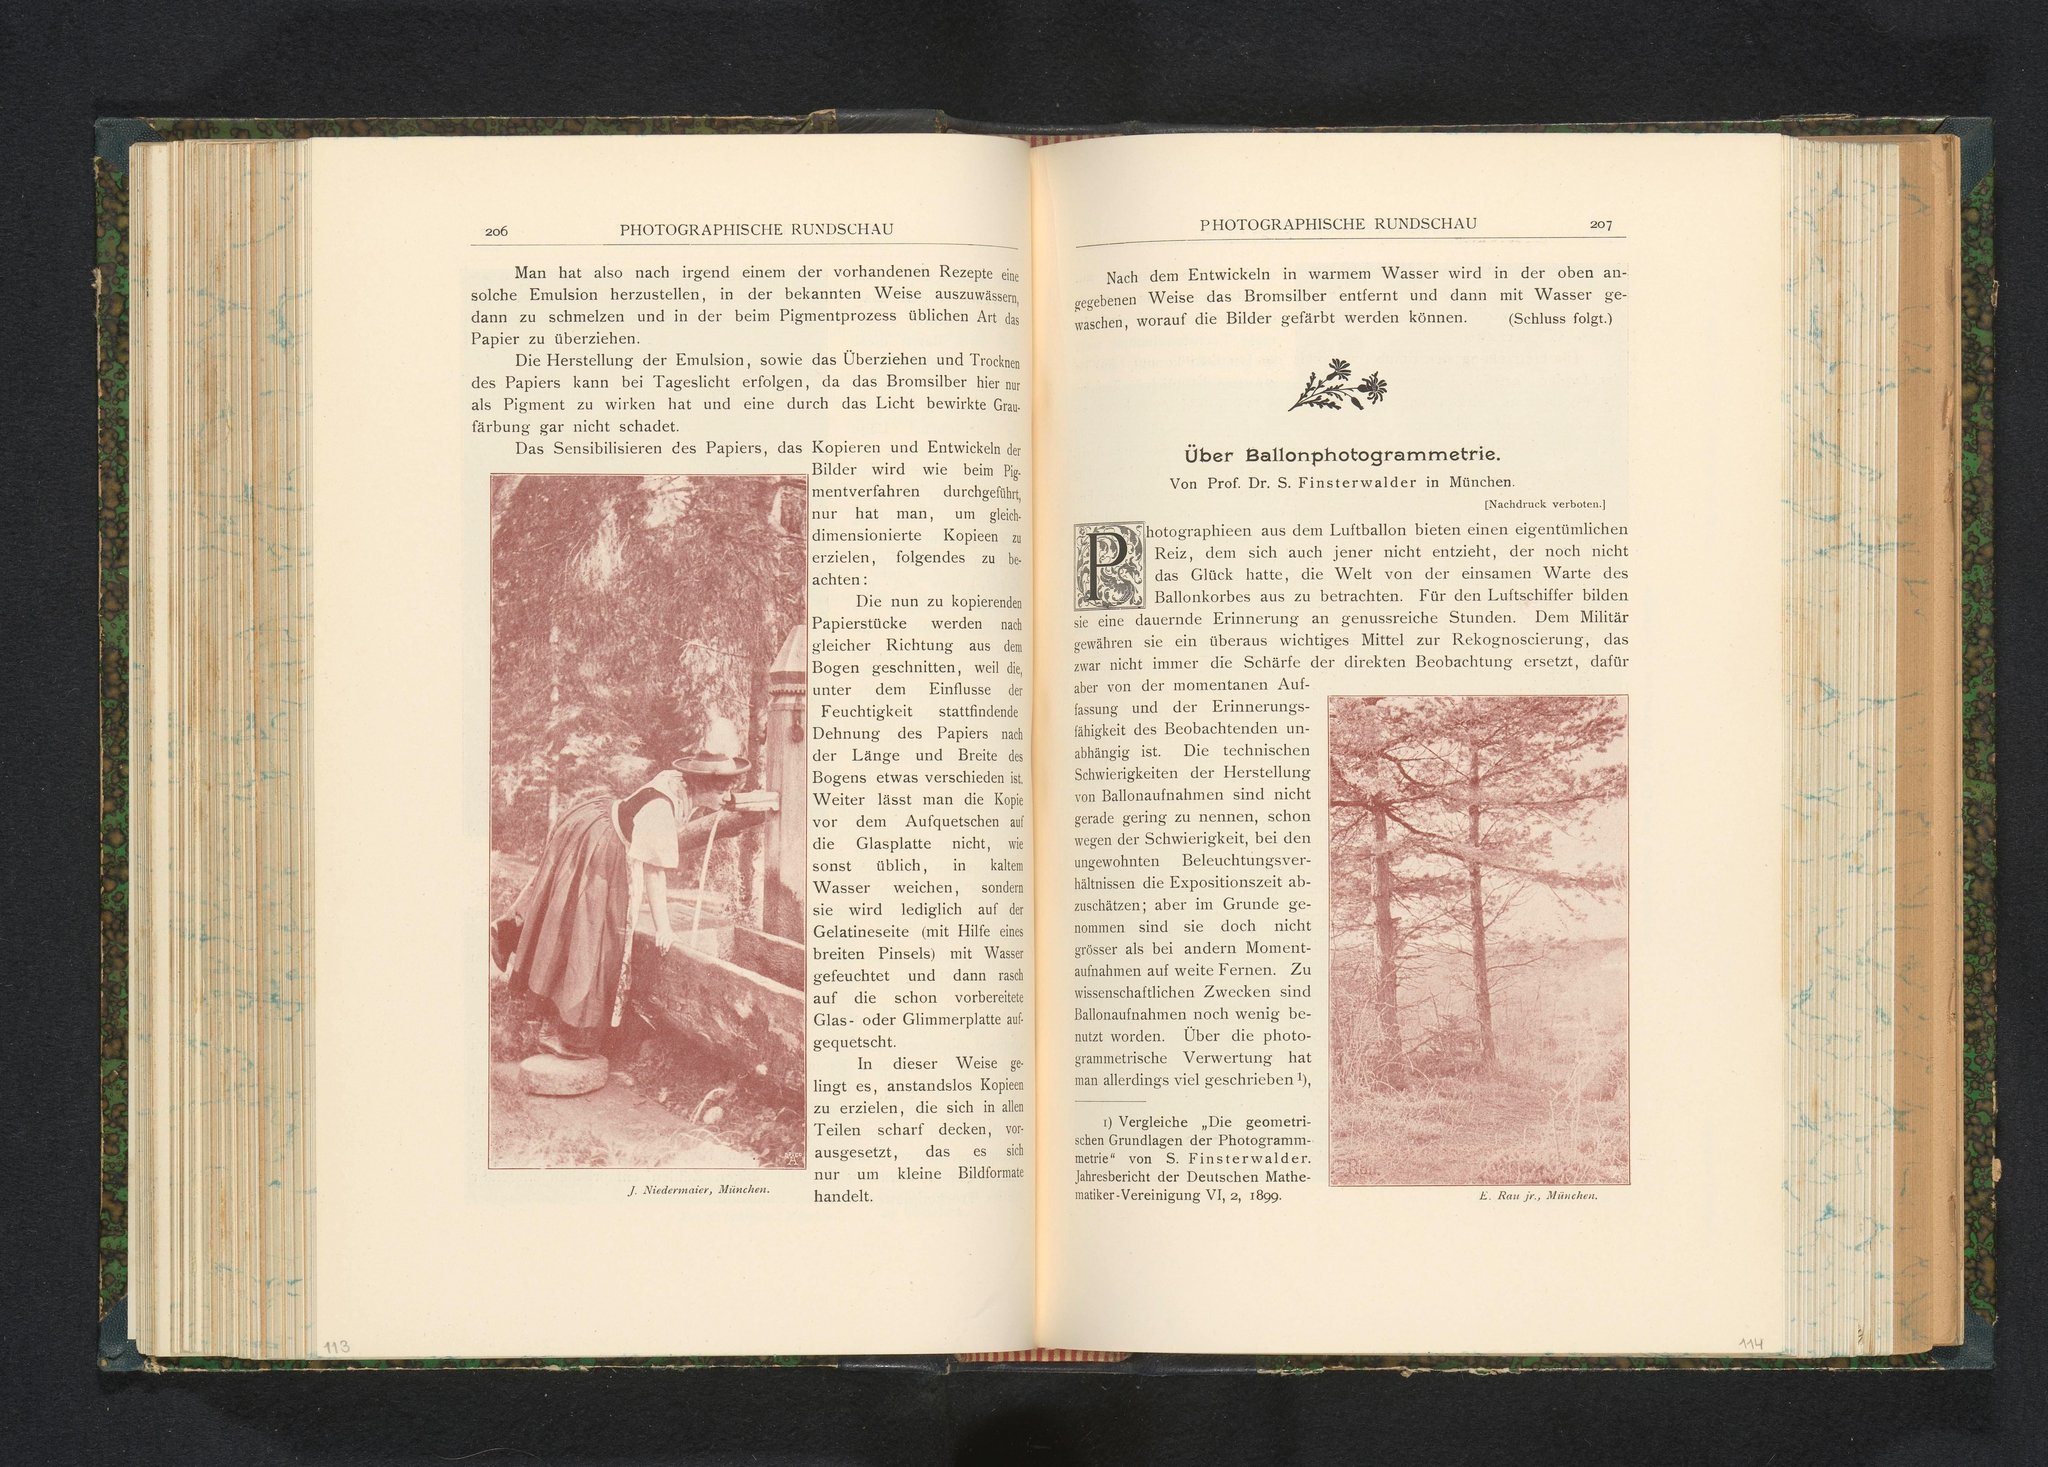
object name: photomechanical print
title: Vrouw drinkt water uit een waterton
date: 1894-1899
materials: paper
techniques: autotype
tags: adult woman, water-supply and draining, pipework (in house or building)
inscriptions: monogram: ‘Dr A Co’